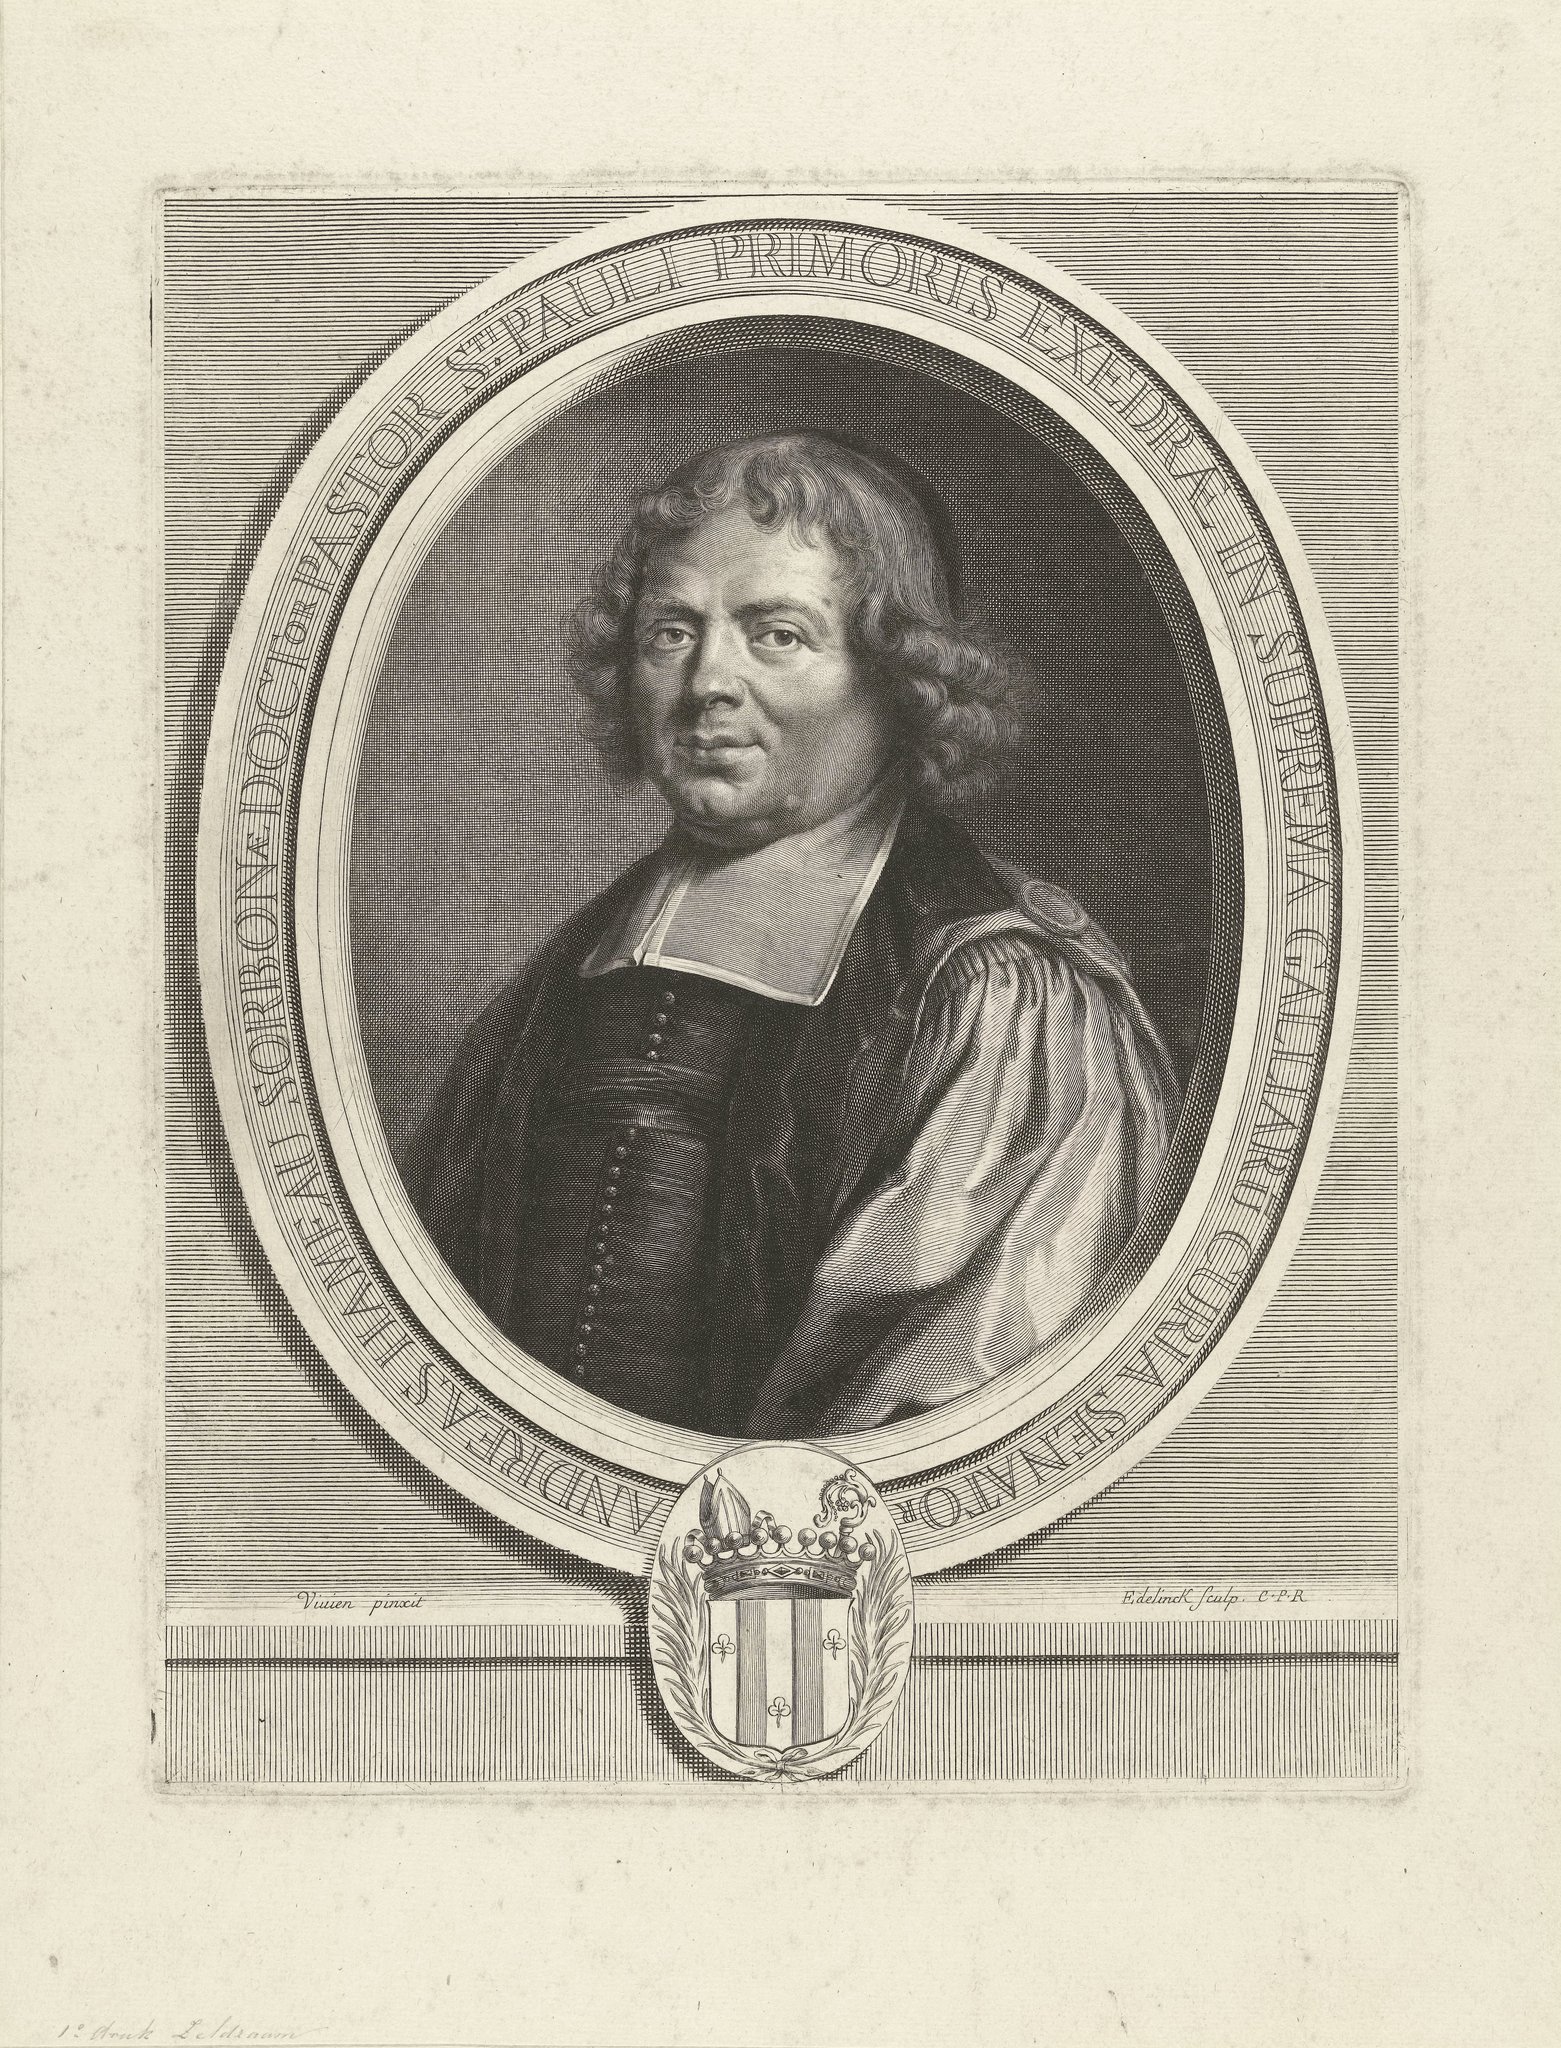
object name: print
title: Portret van André Hameau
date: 1666-1707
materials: paper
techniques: engraving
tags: andré hameau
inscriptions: collector's mark: Lugt 240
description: Portret van André Hameau, pastoor van de Saint-Paul in Parijs, afgebeeld in ovale omlijsting met tekst en wapen.